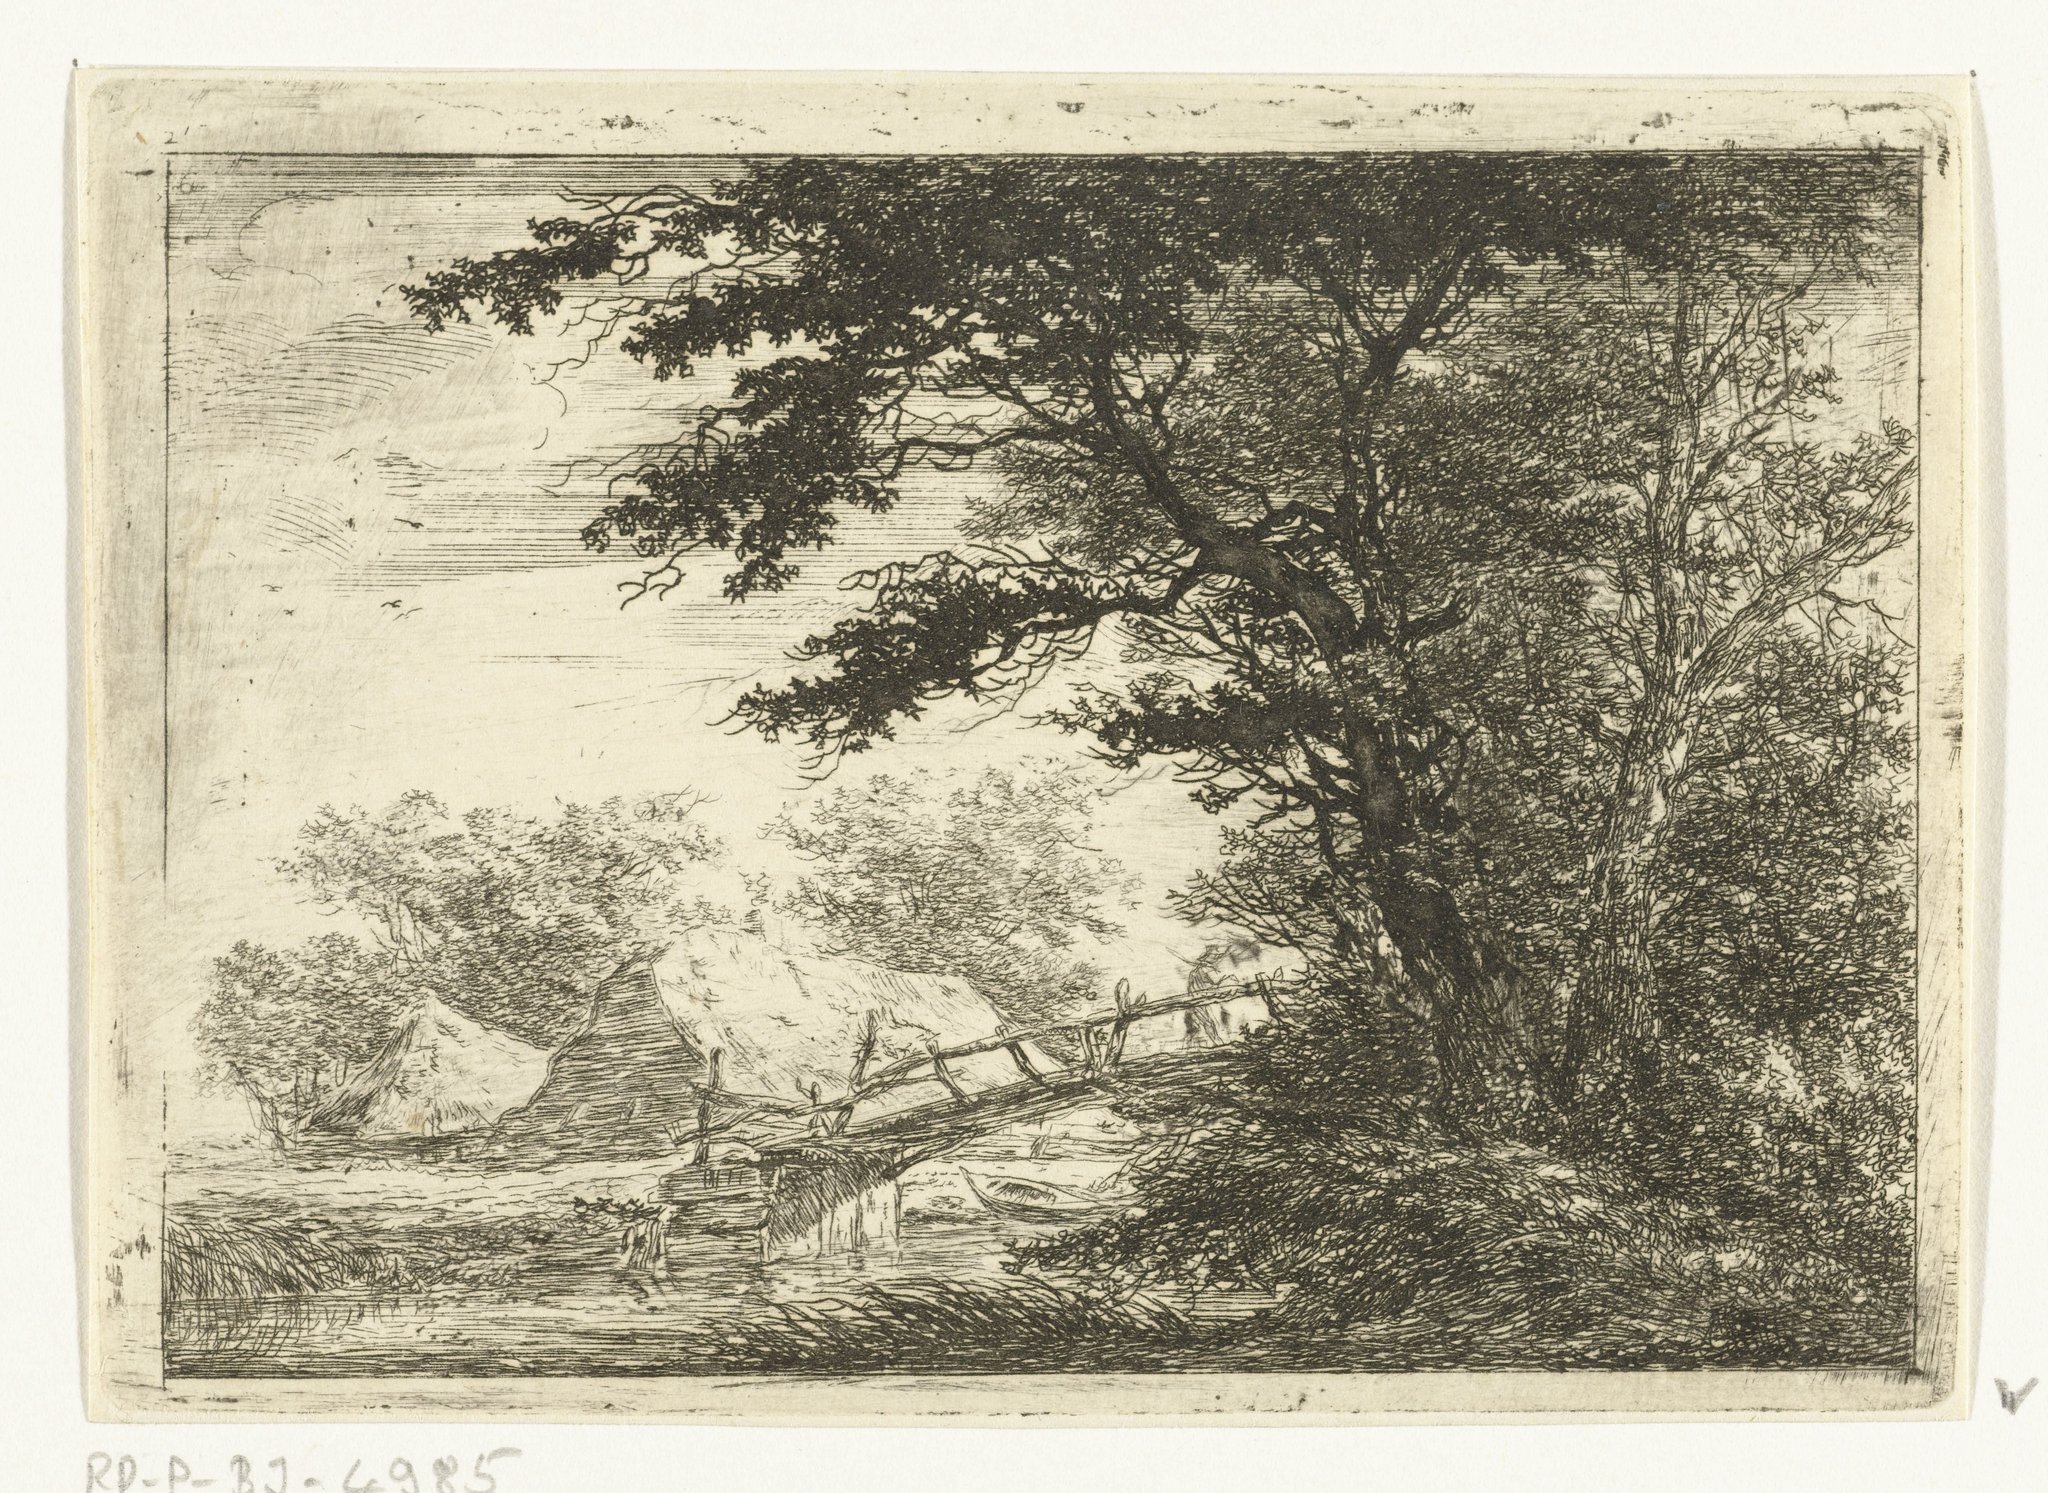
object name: print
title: Rustende figuren bij hoge bomen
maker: hermanus van brussel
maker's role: draughtsman, print maker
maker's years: 1763-1815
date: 1800-1815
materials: paper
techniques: etching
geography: netherlands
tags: forest, wood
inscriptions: collector's mark: Lugt 2228